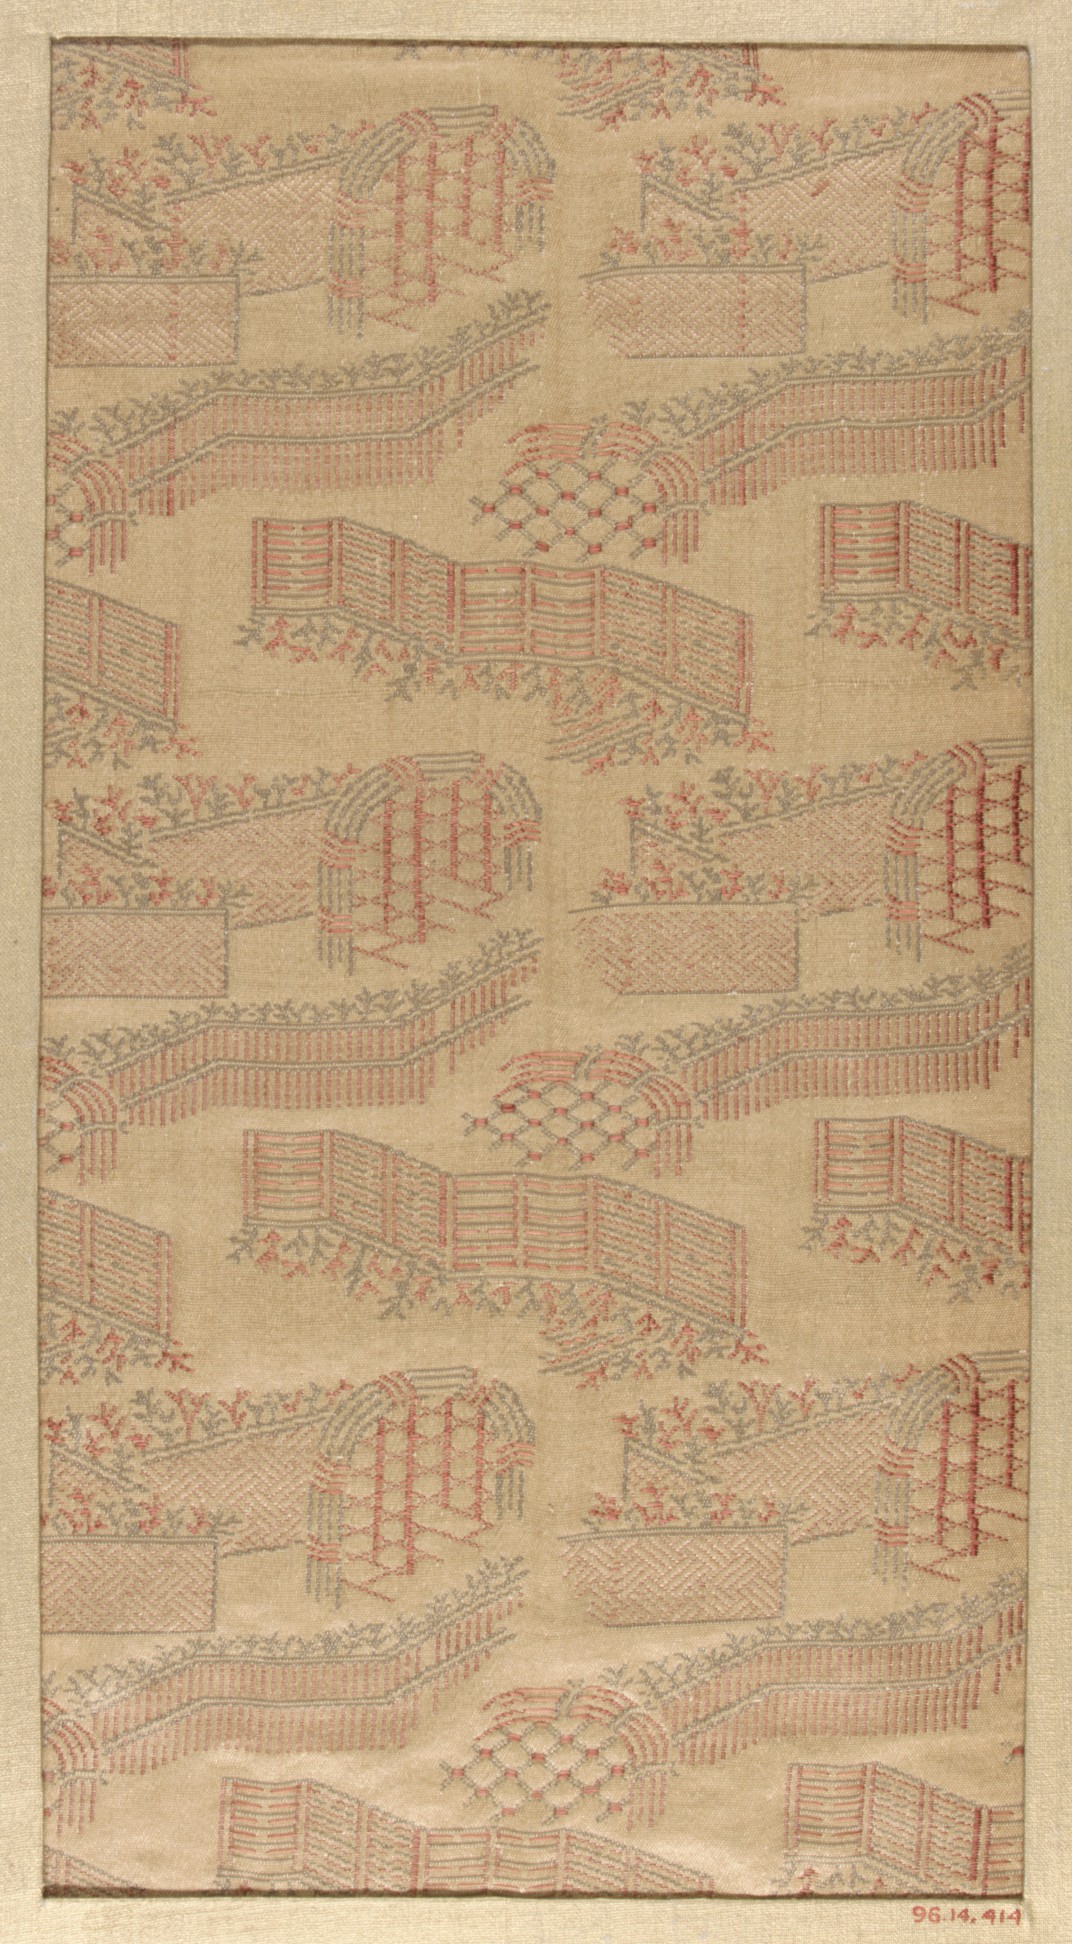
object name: piece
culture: japanese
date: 1701-1900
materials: silk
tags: fences